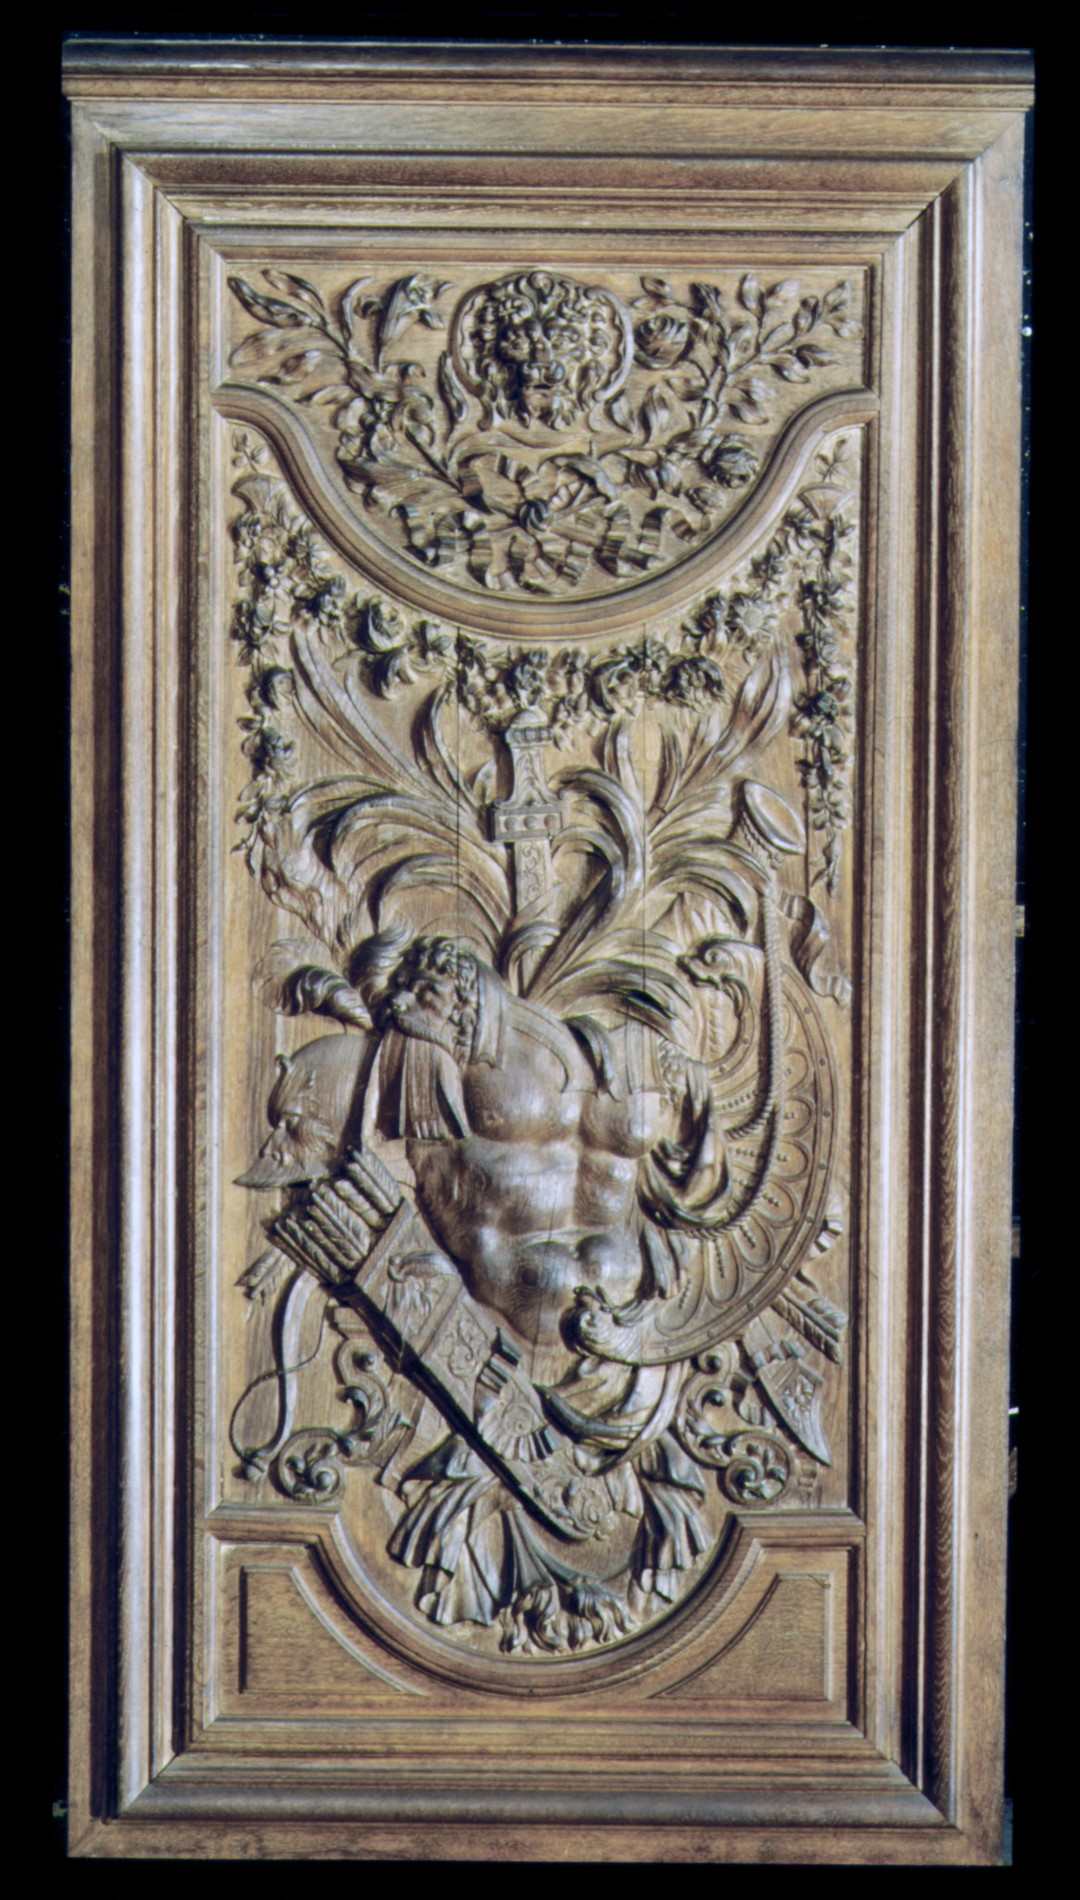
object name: panel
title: Panels (part of a set)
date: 1676-1700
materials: wood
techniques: carving, gilding, painting